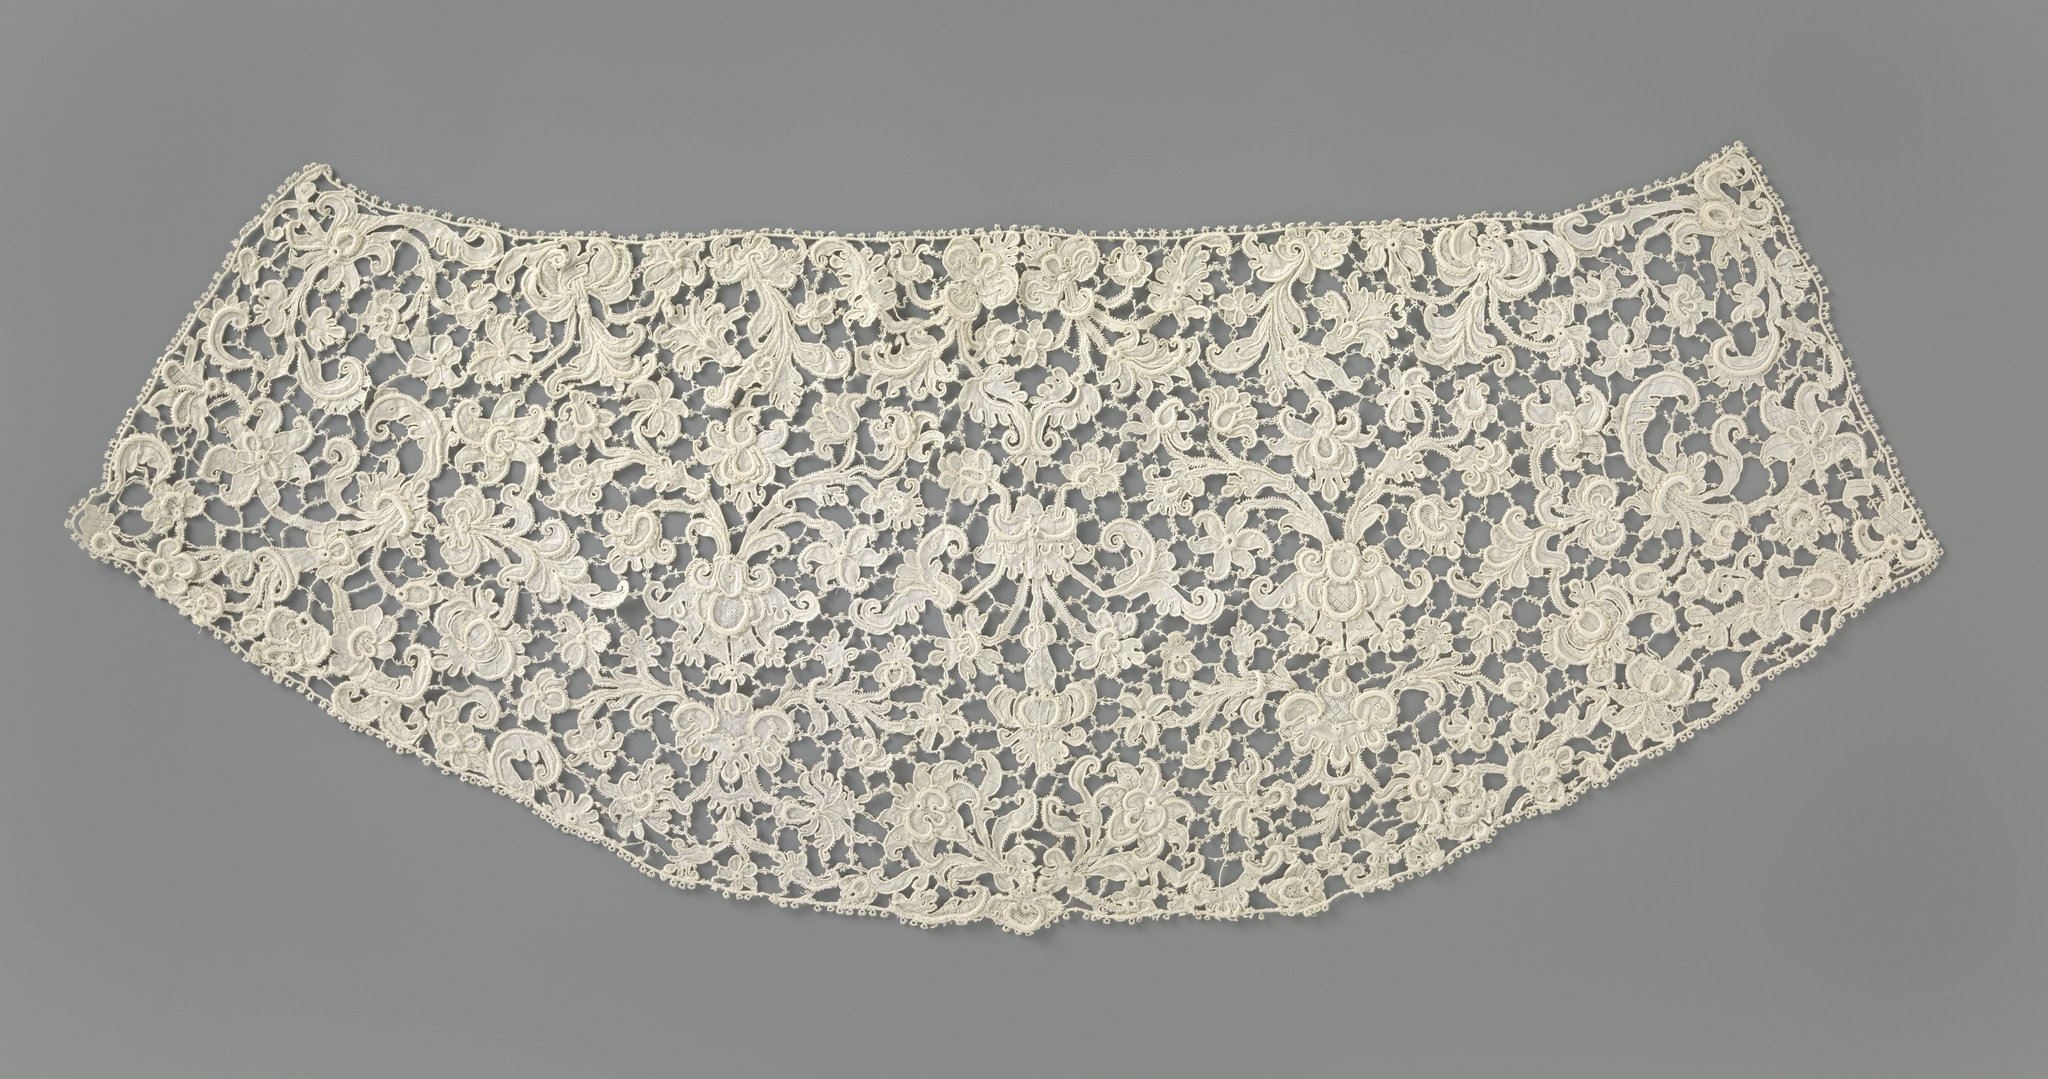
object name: jabot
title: Jabot van naaldkant met waaiervormige palmetten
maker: Anonymous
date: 1690-1699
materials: linen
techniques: embroidery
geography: venice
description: Jabot van naturelkleurige naaldkant: Venetiaanse reliëfkant. Waaiervormig geknipt. In het midden en terzijden zijn staande naden zichtbaar. In de grote middenstukken, met een over het algemeen symmetrisch patroon, staan waaiervormige palmetten boven twee hangende ranken met bloemen, onder een kleinere gevarieerde palmet. Het patroon van de ranken en stervormige bloemen is zeer gedetailleerd uitgevoerd en steekt helder af tegen een open spijlengrond.